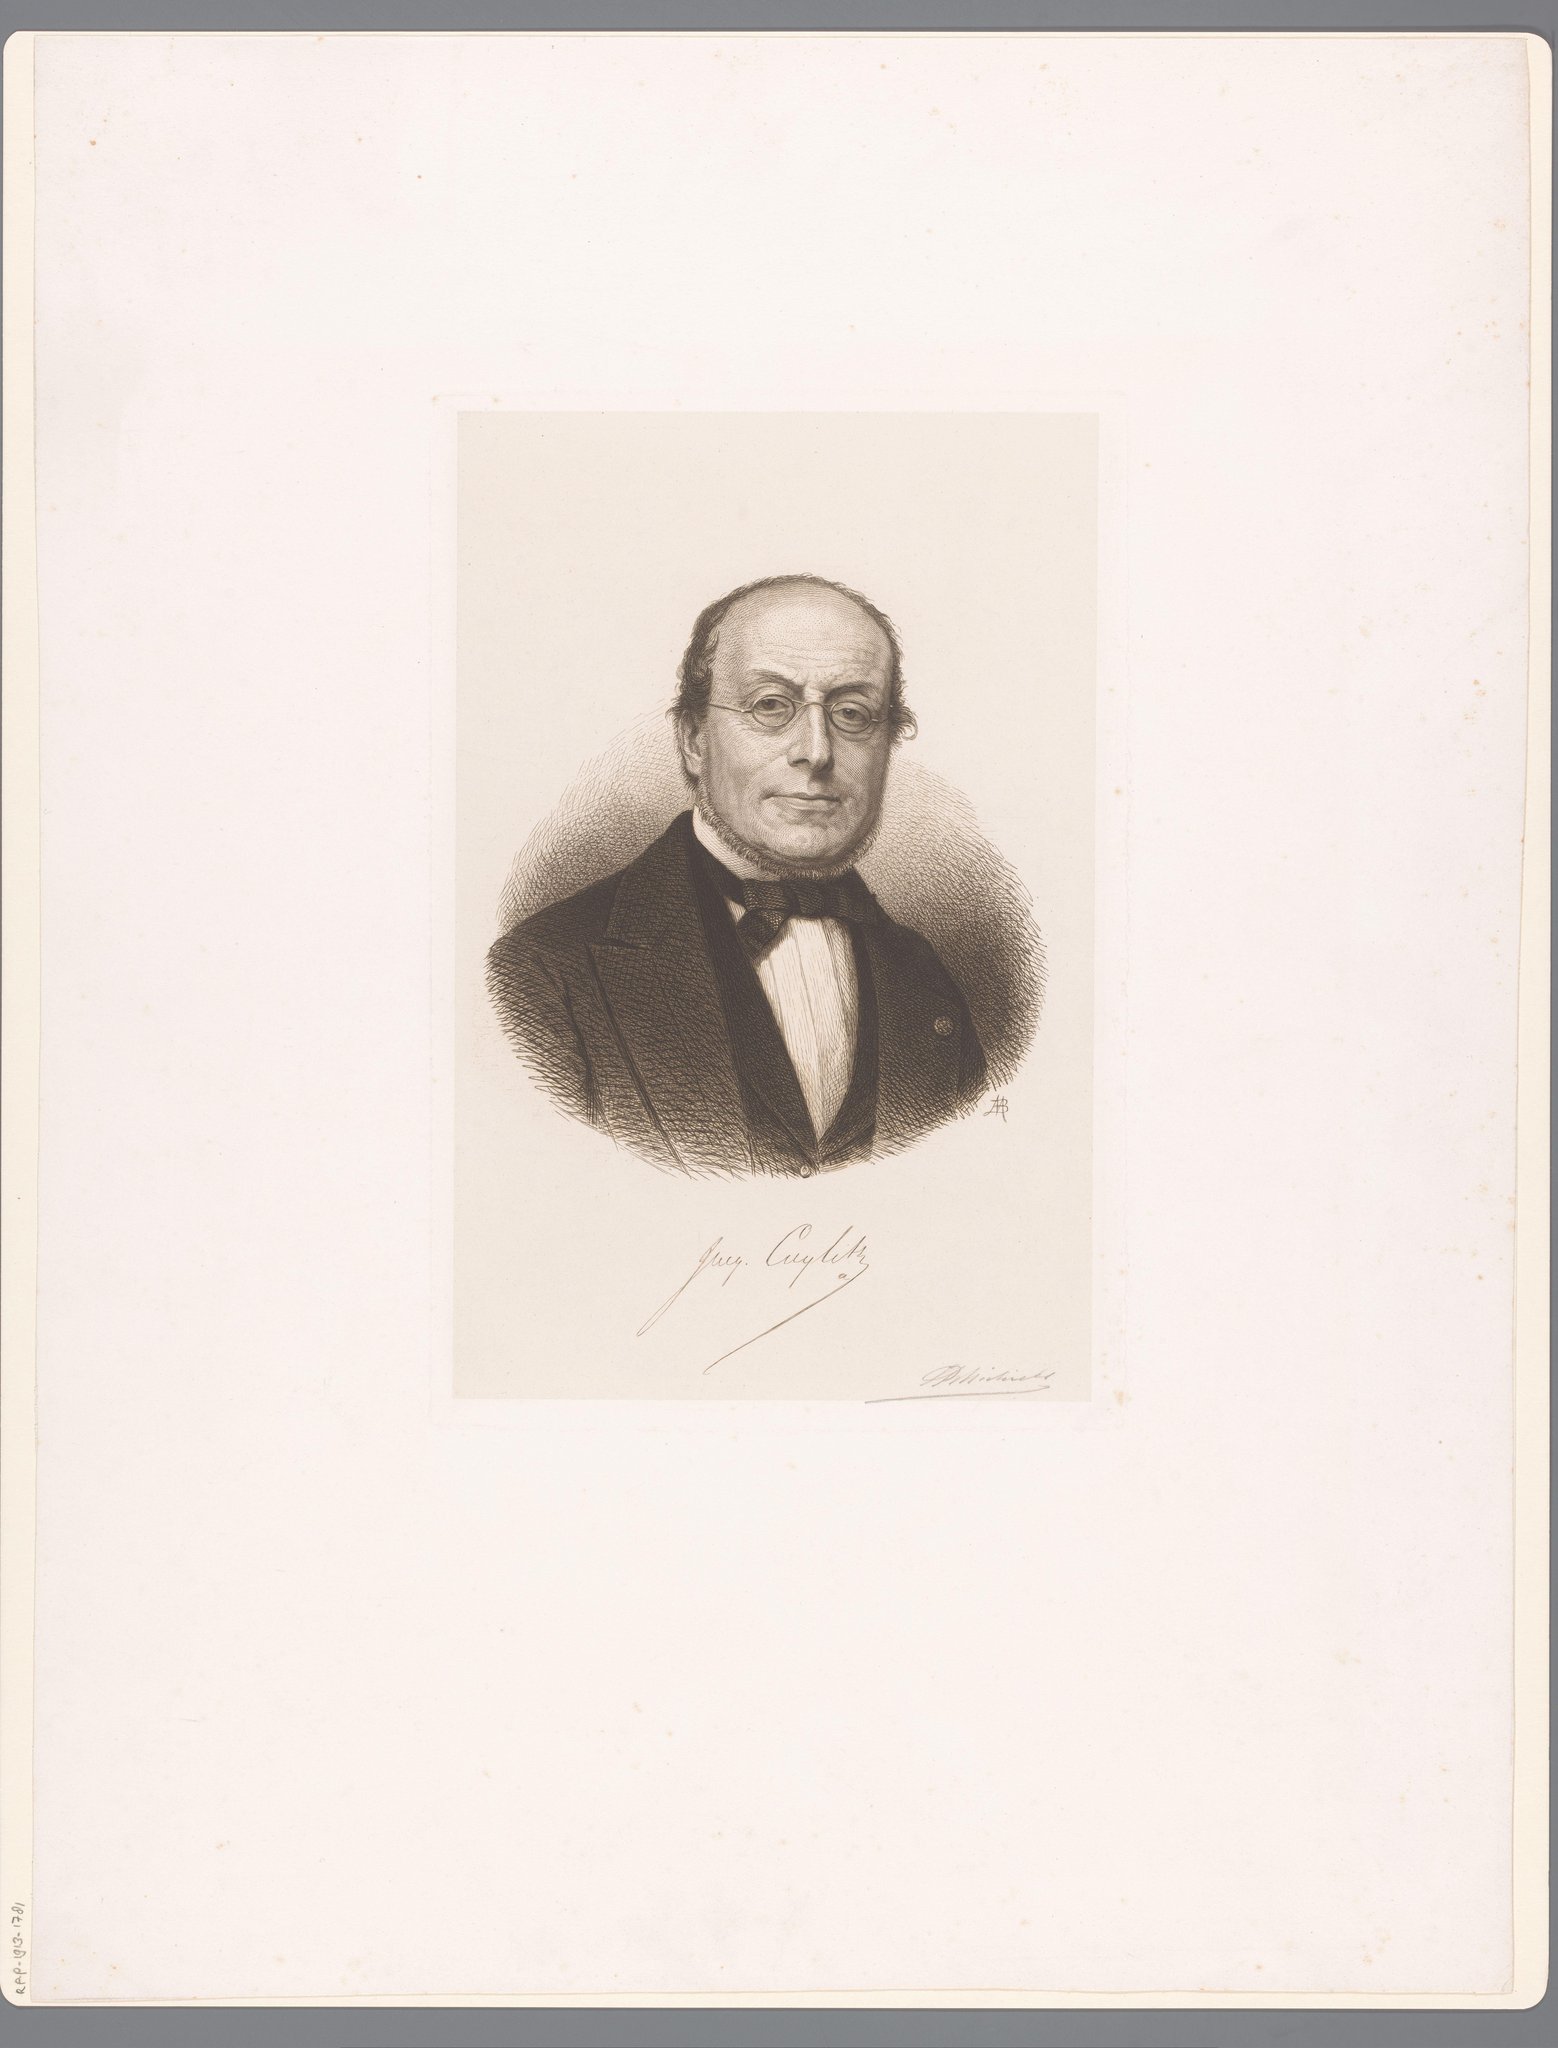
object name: print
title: Portret van Jacques Cuylits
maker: jean baptiste pierre michiels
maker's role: print maker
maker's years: 1821-1890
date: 1831-1890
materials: paper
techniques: etching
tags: eyeglasses, spectacles, adult man, historical persons, beard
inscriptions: collector's mark: Lugt 2228